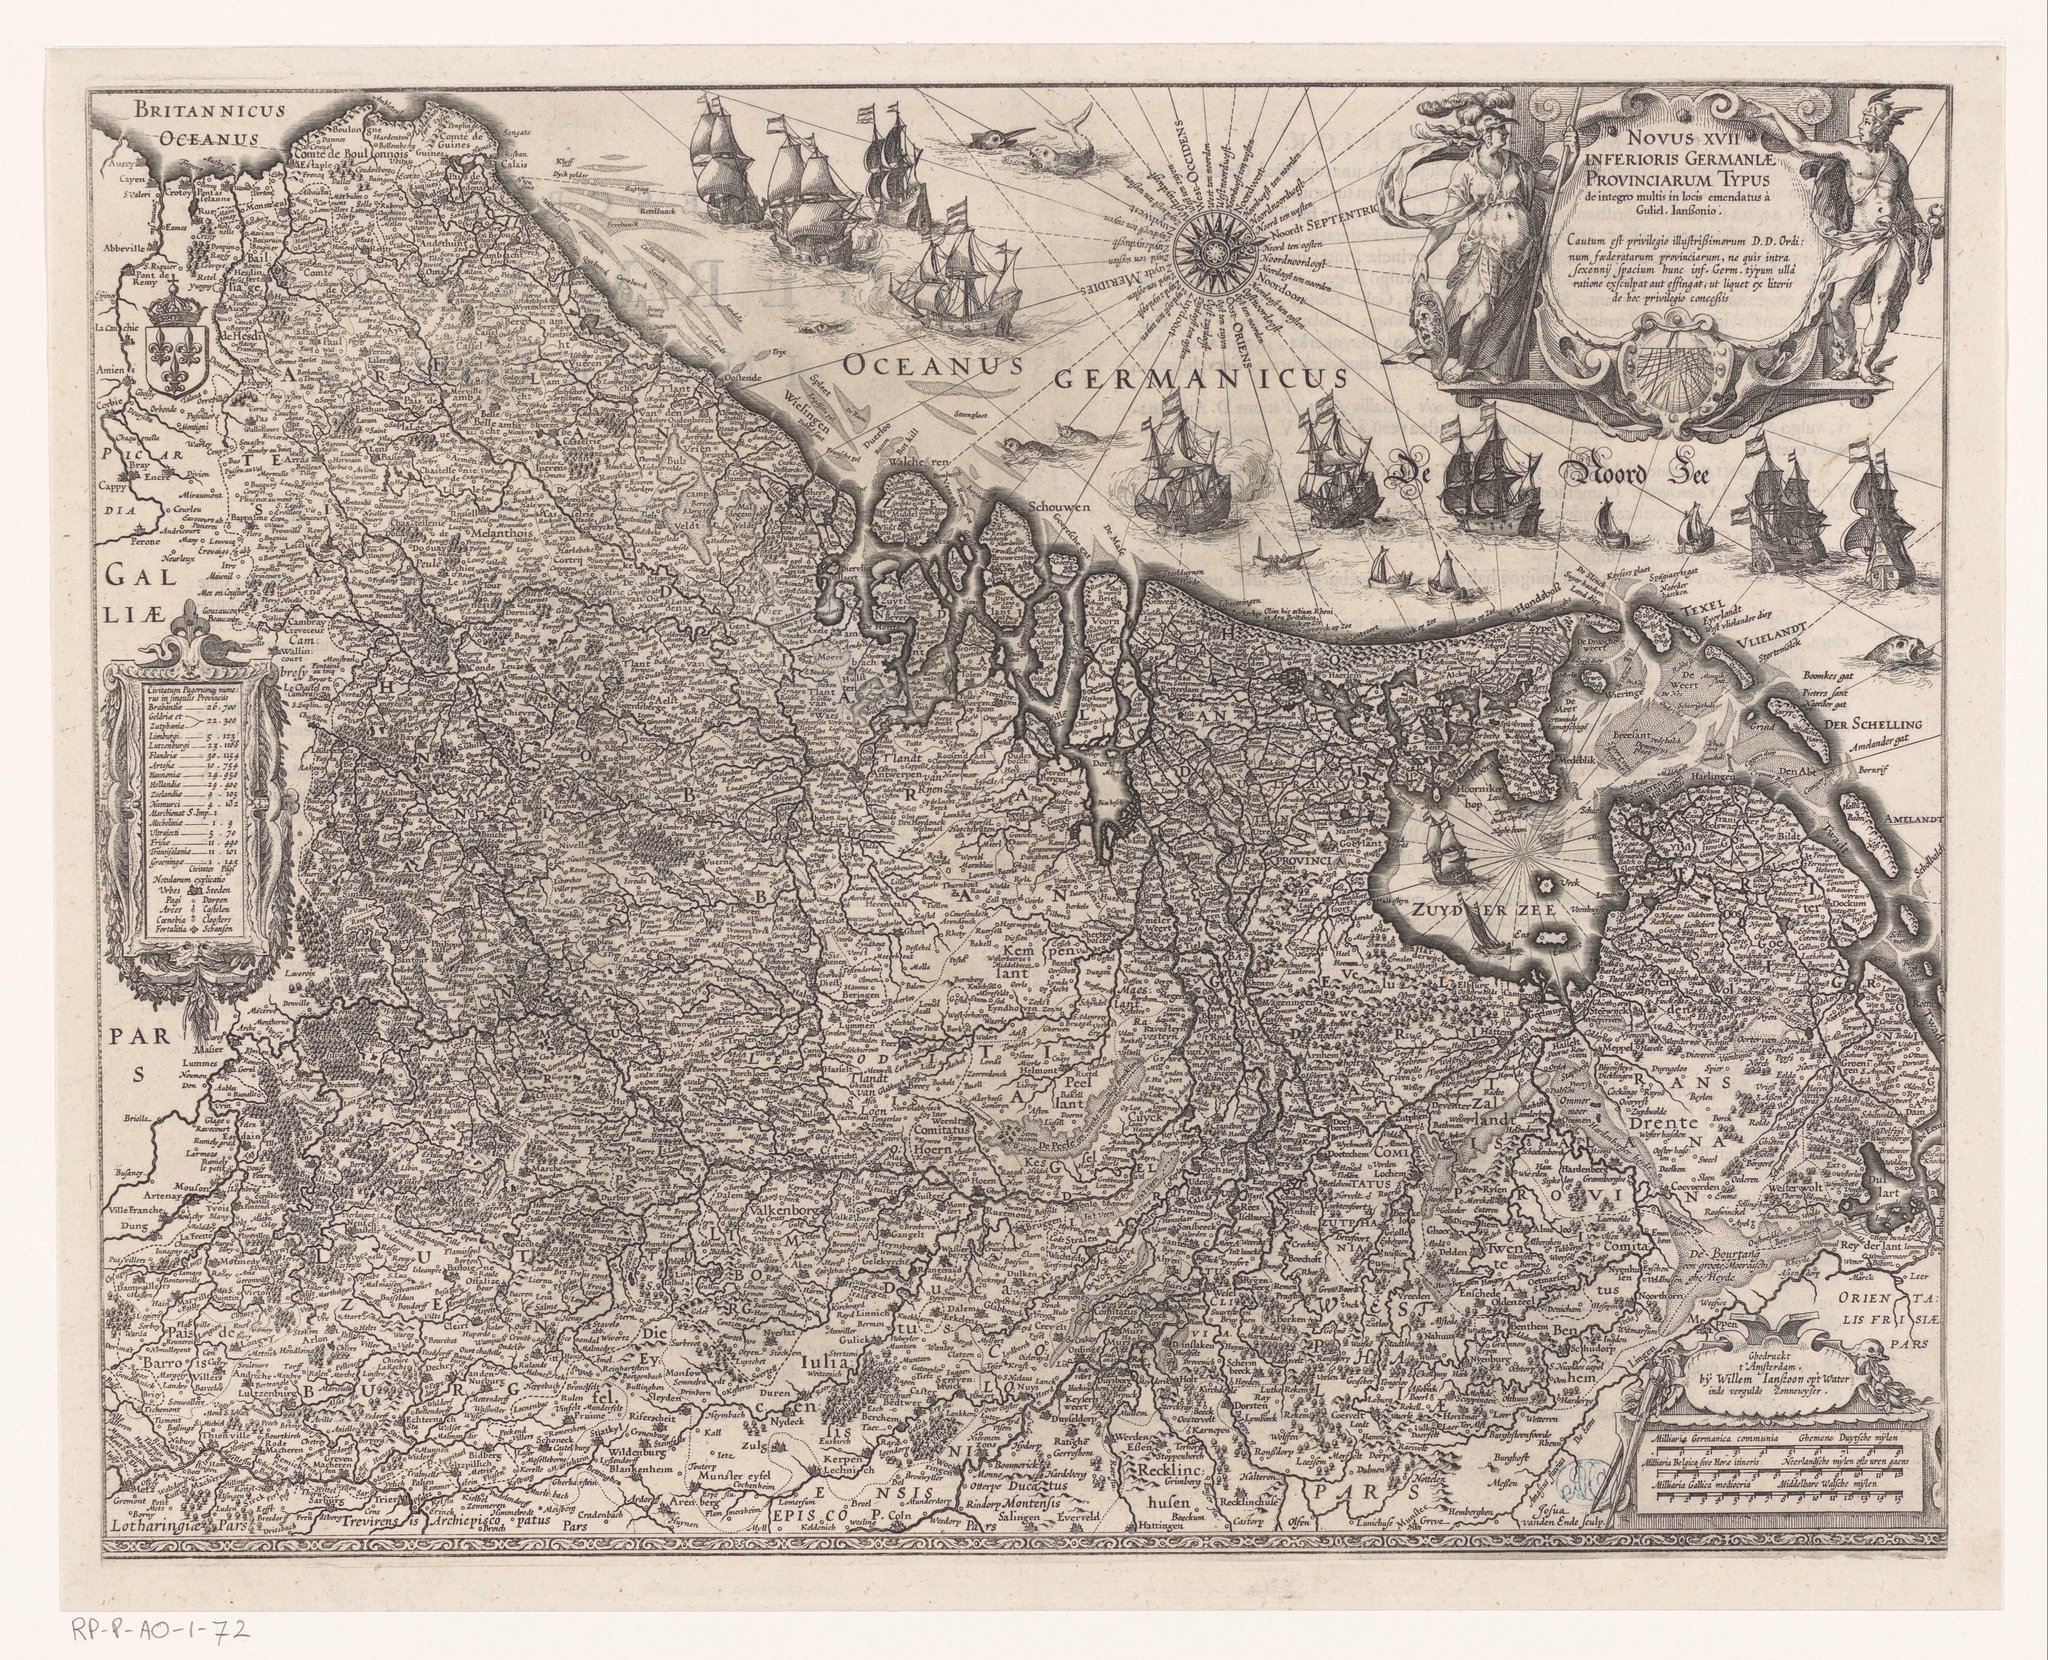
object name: map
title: Kaart van de Zeventien Provinciën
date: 1608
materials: paper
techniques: engraving, etching, letterpress printing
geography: amsterdam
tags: maps of separate countries or regions, (story of) minerva (pallas, athena), (story of) mercury (hermes), low countries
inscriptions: collector's mark: Lugt 2228, collector's mark: Lugt 195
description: Links cartouche met topografische informatie over de Zeventien Provinciën en legenda. Rechtsboven titelcartouche met daaromheen Minerva en Mercurius. Rechtsonder drie schaalstokken: Milliaria Germanica communia / Ghemene Duytsche mijlen, Milliaria Belgica sive hore itineris / Neerlandsche mylen ofte uren gaens, Milliaria Gallica mediocria / Middelbare Walsche mijlen. Oriëntatie: het noorden rechts. Op verso Latijnse tekst.